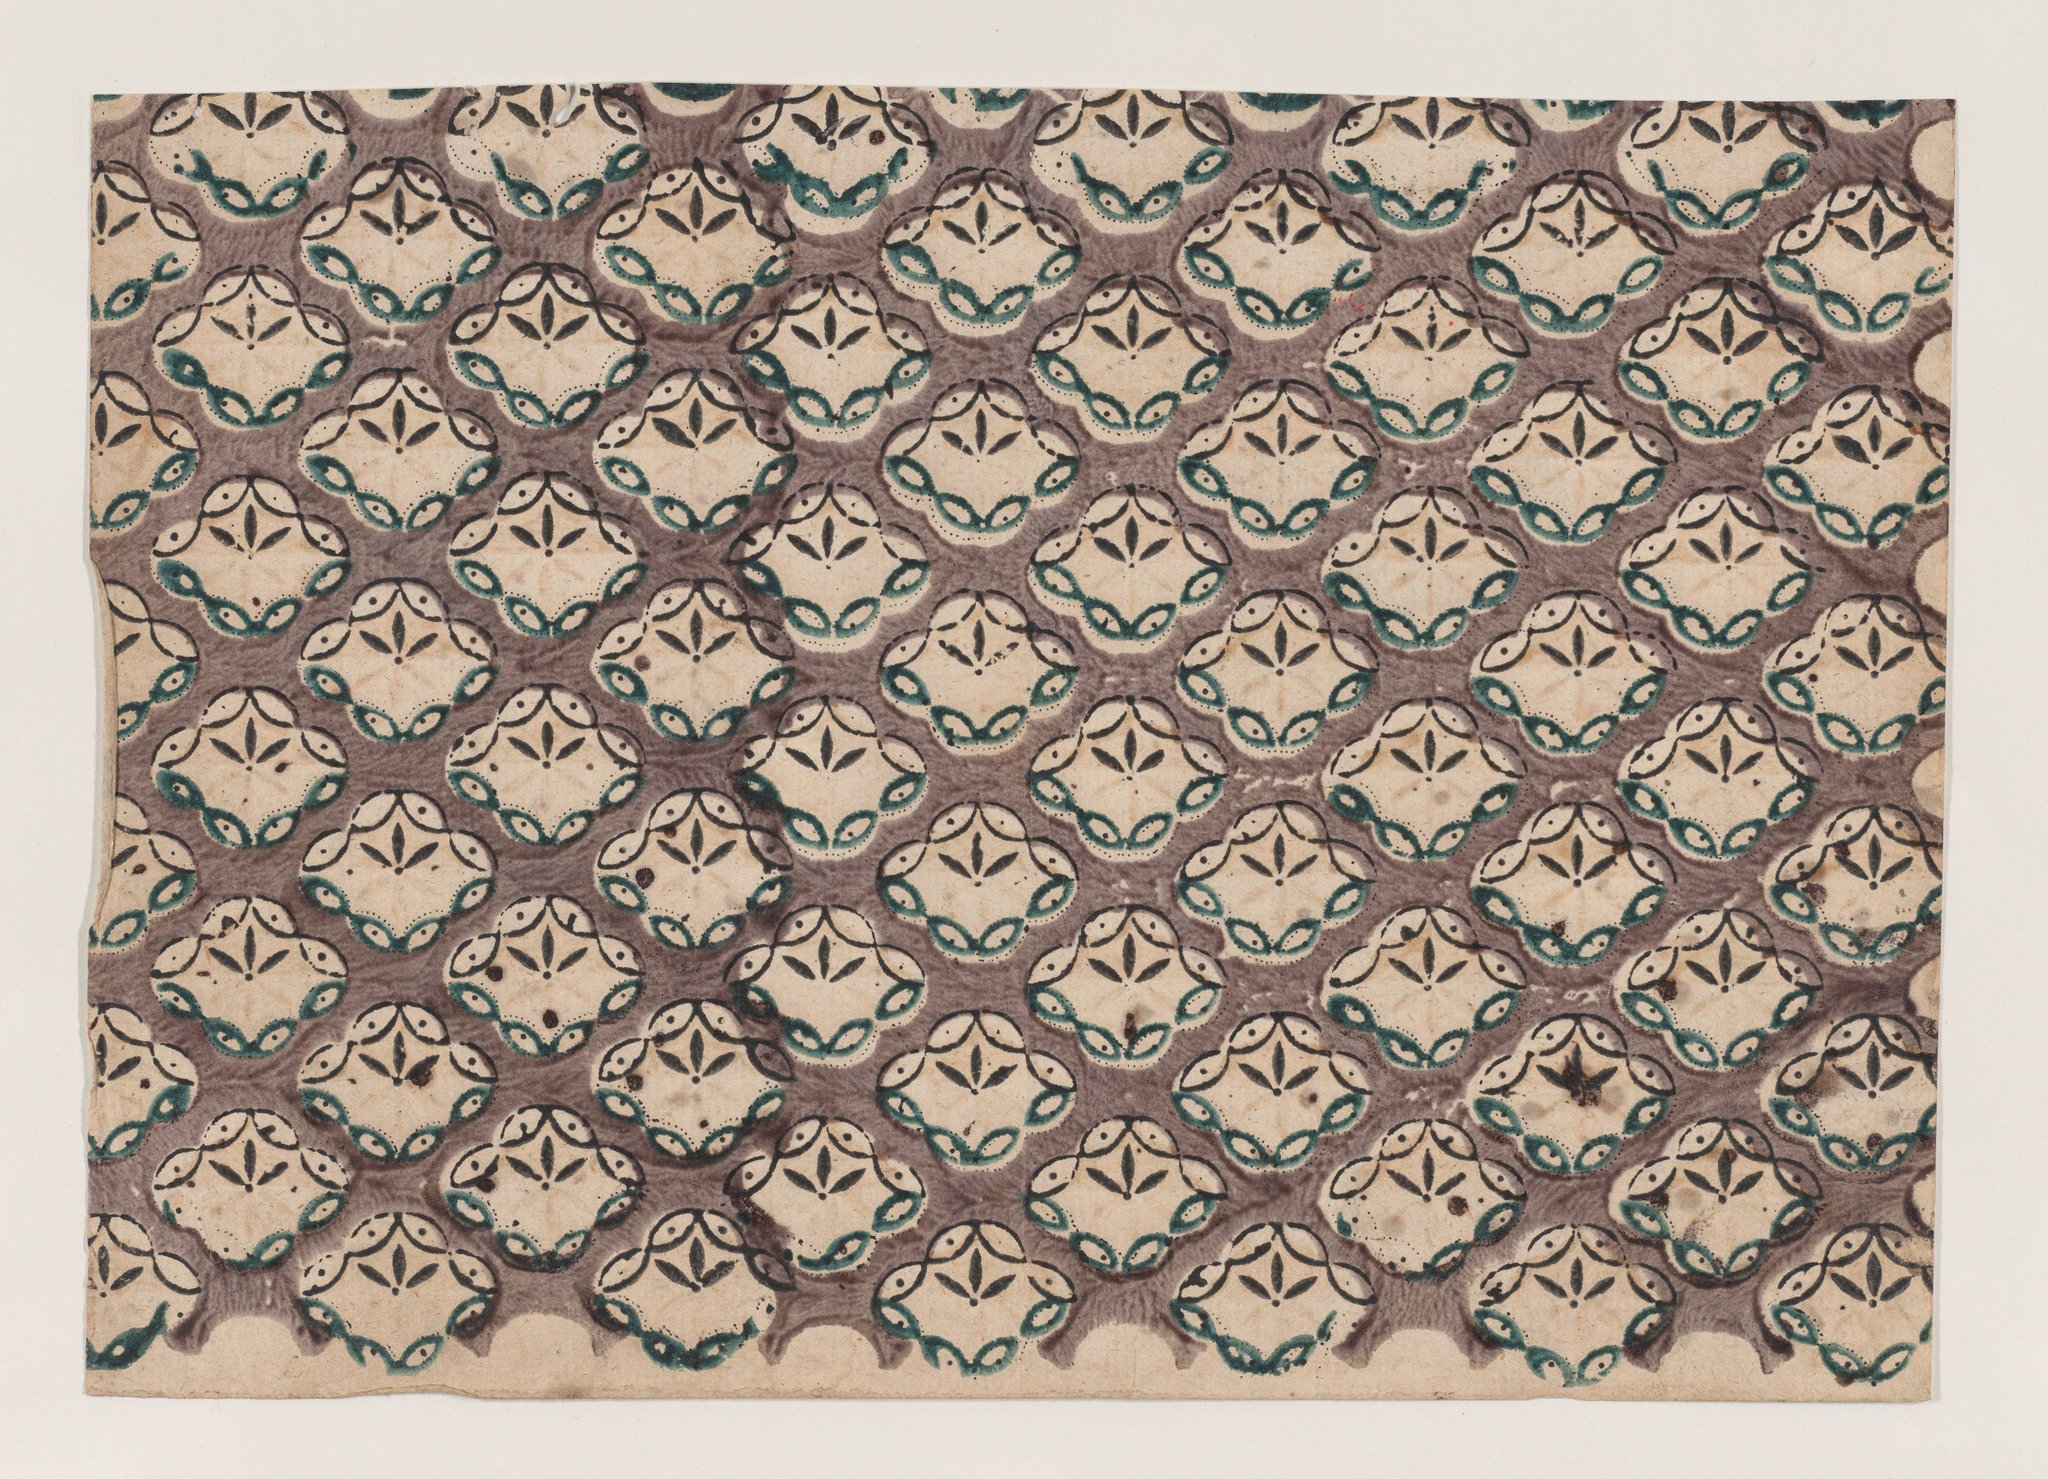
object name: print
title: Sheet with overall abstract pattern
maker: Anonymous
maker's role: artist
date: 1801-1900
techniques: relief print